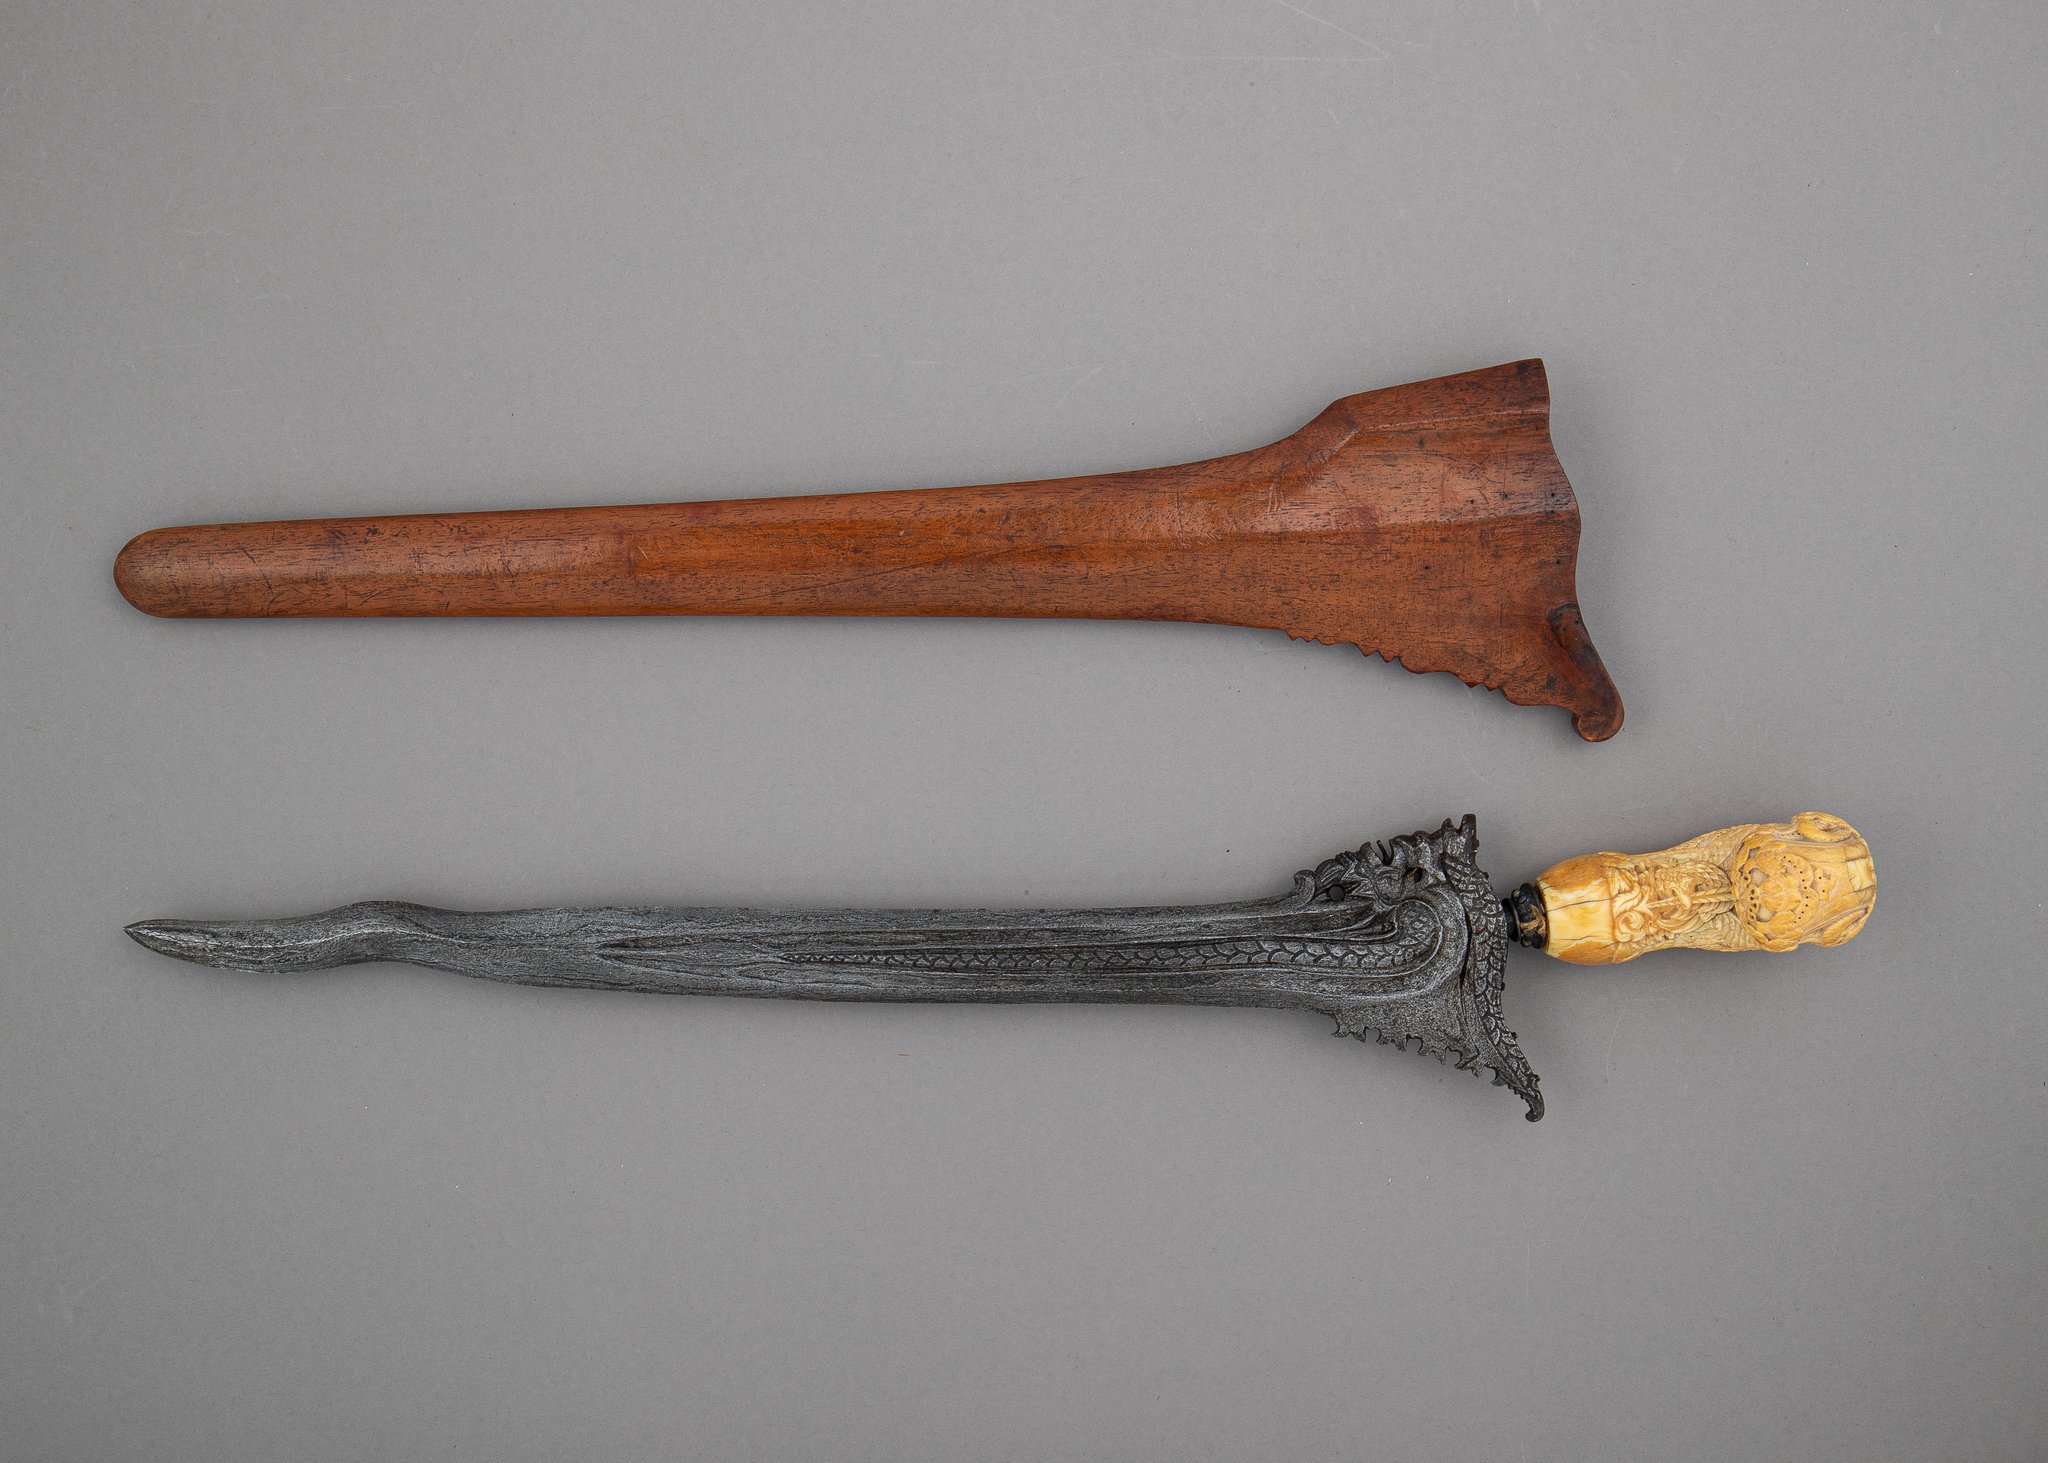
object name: kris with sheath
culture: javanese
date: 1501-1900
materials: ivory, steel, wood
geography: indonesia